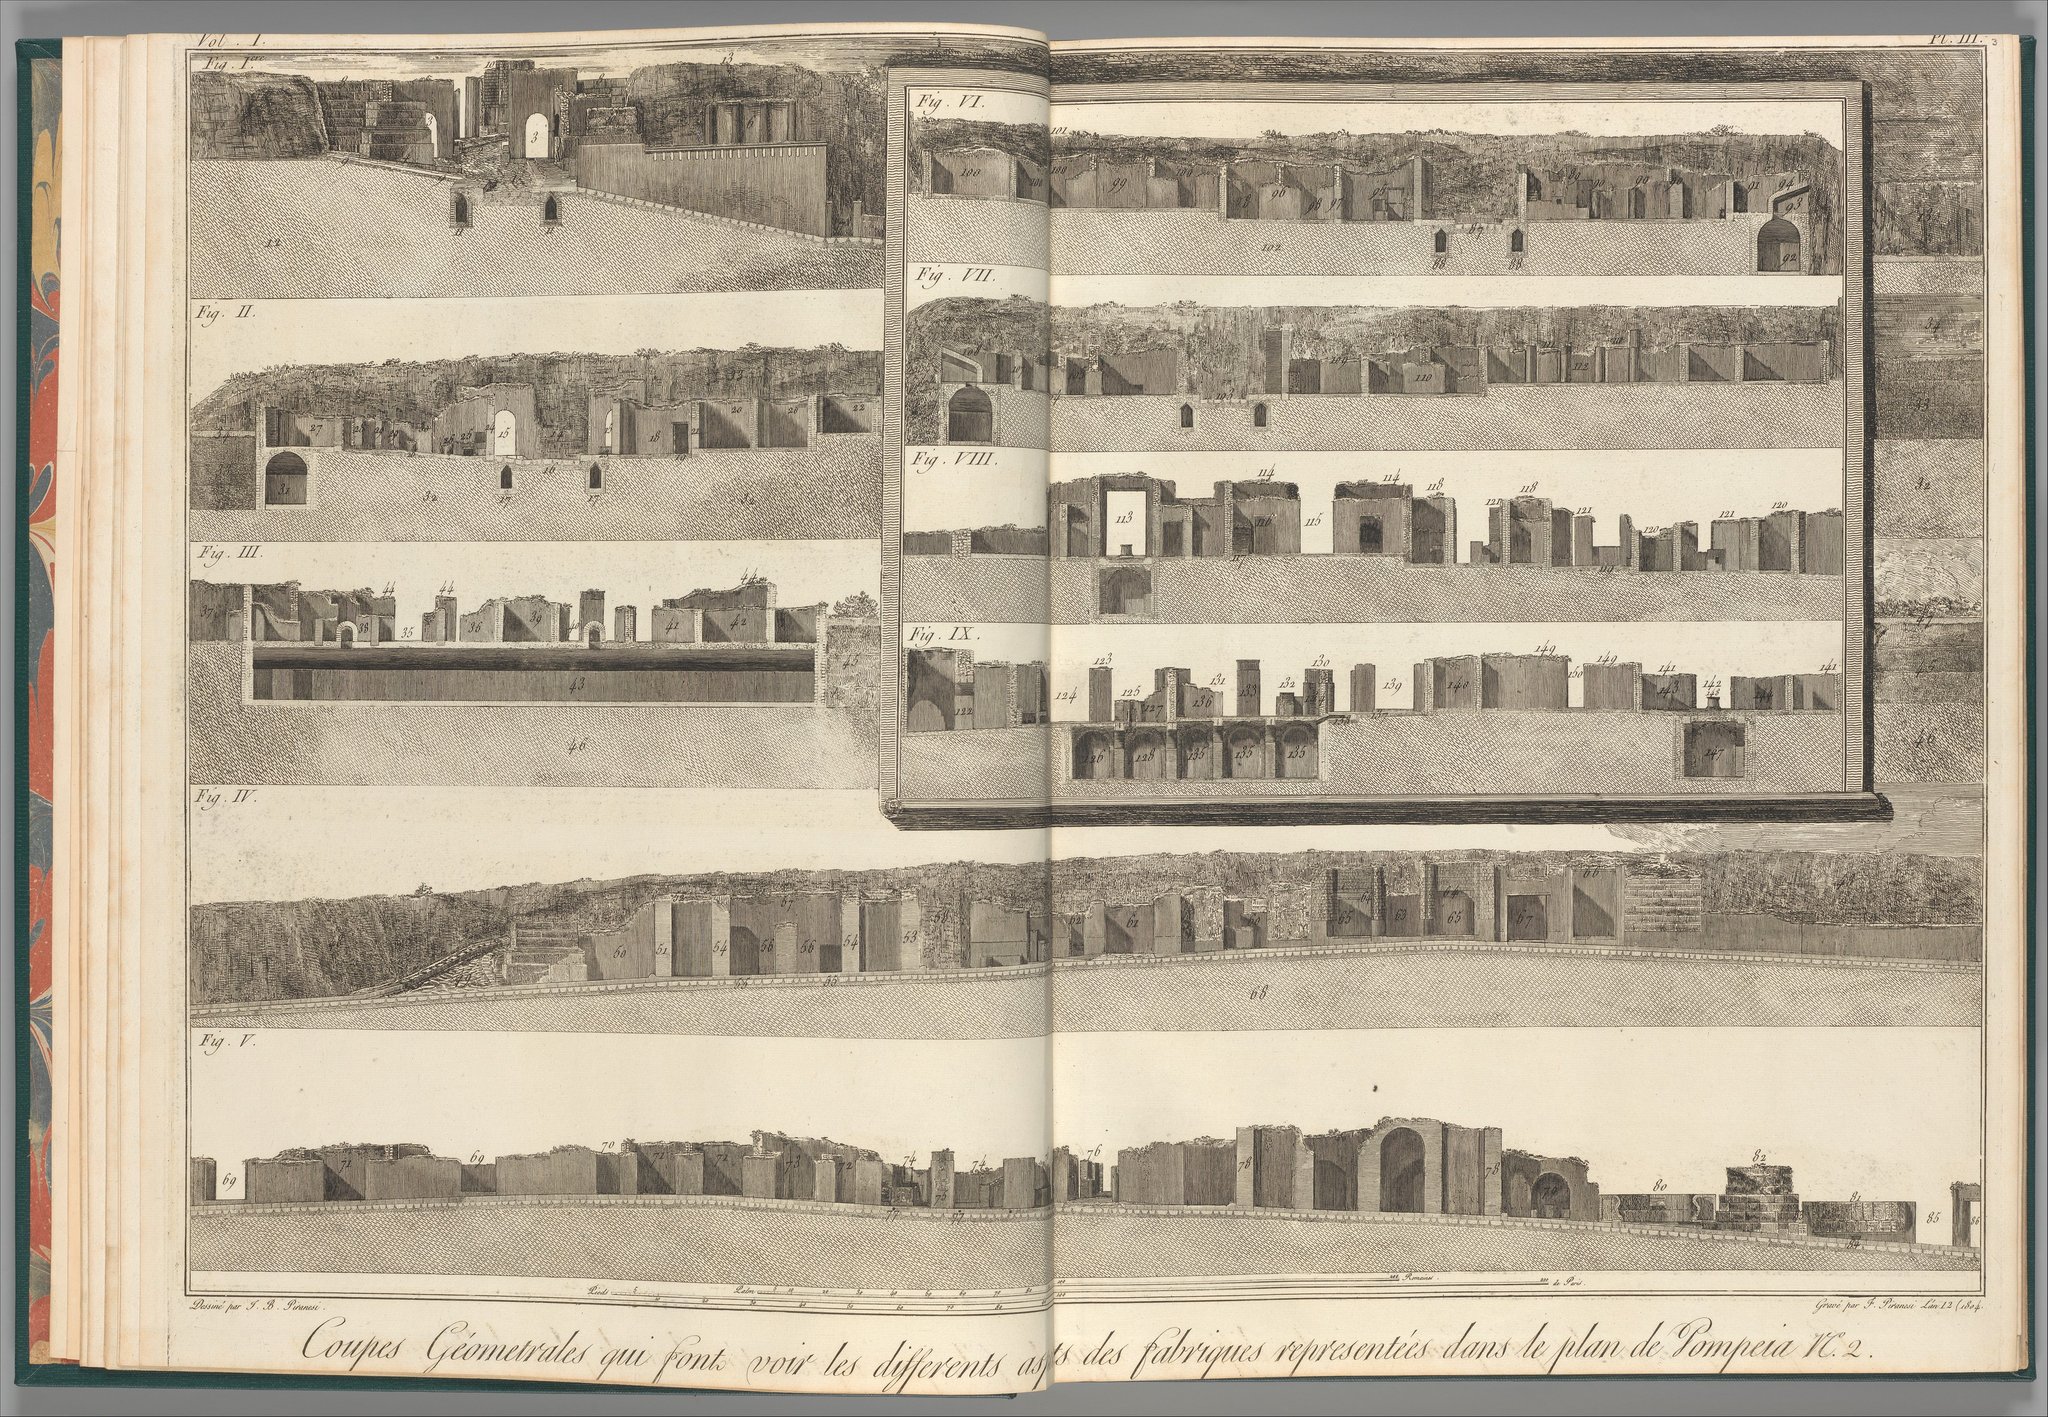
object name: print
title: Cross-sections, which show the different aspects of the buildings shown in the plan of Pompeii [the preceding plate], from "Antiquités de Pompeïa, tome premier, Antiquités de la Grande Grèce..." (Antiquities of Pompeii, volume one, Antiquities of Great Greece...), volume 1, plate 3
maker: francesco piranesi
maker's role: artist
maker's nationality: italian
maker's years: 1758-1810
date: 1804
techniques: etching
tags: architecture,buildings